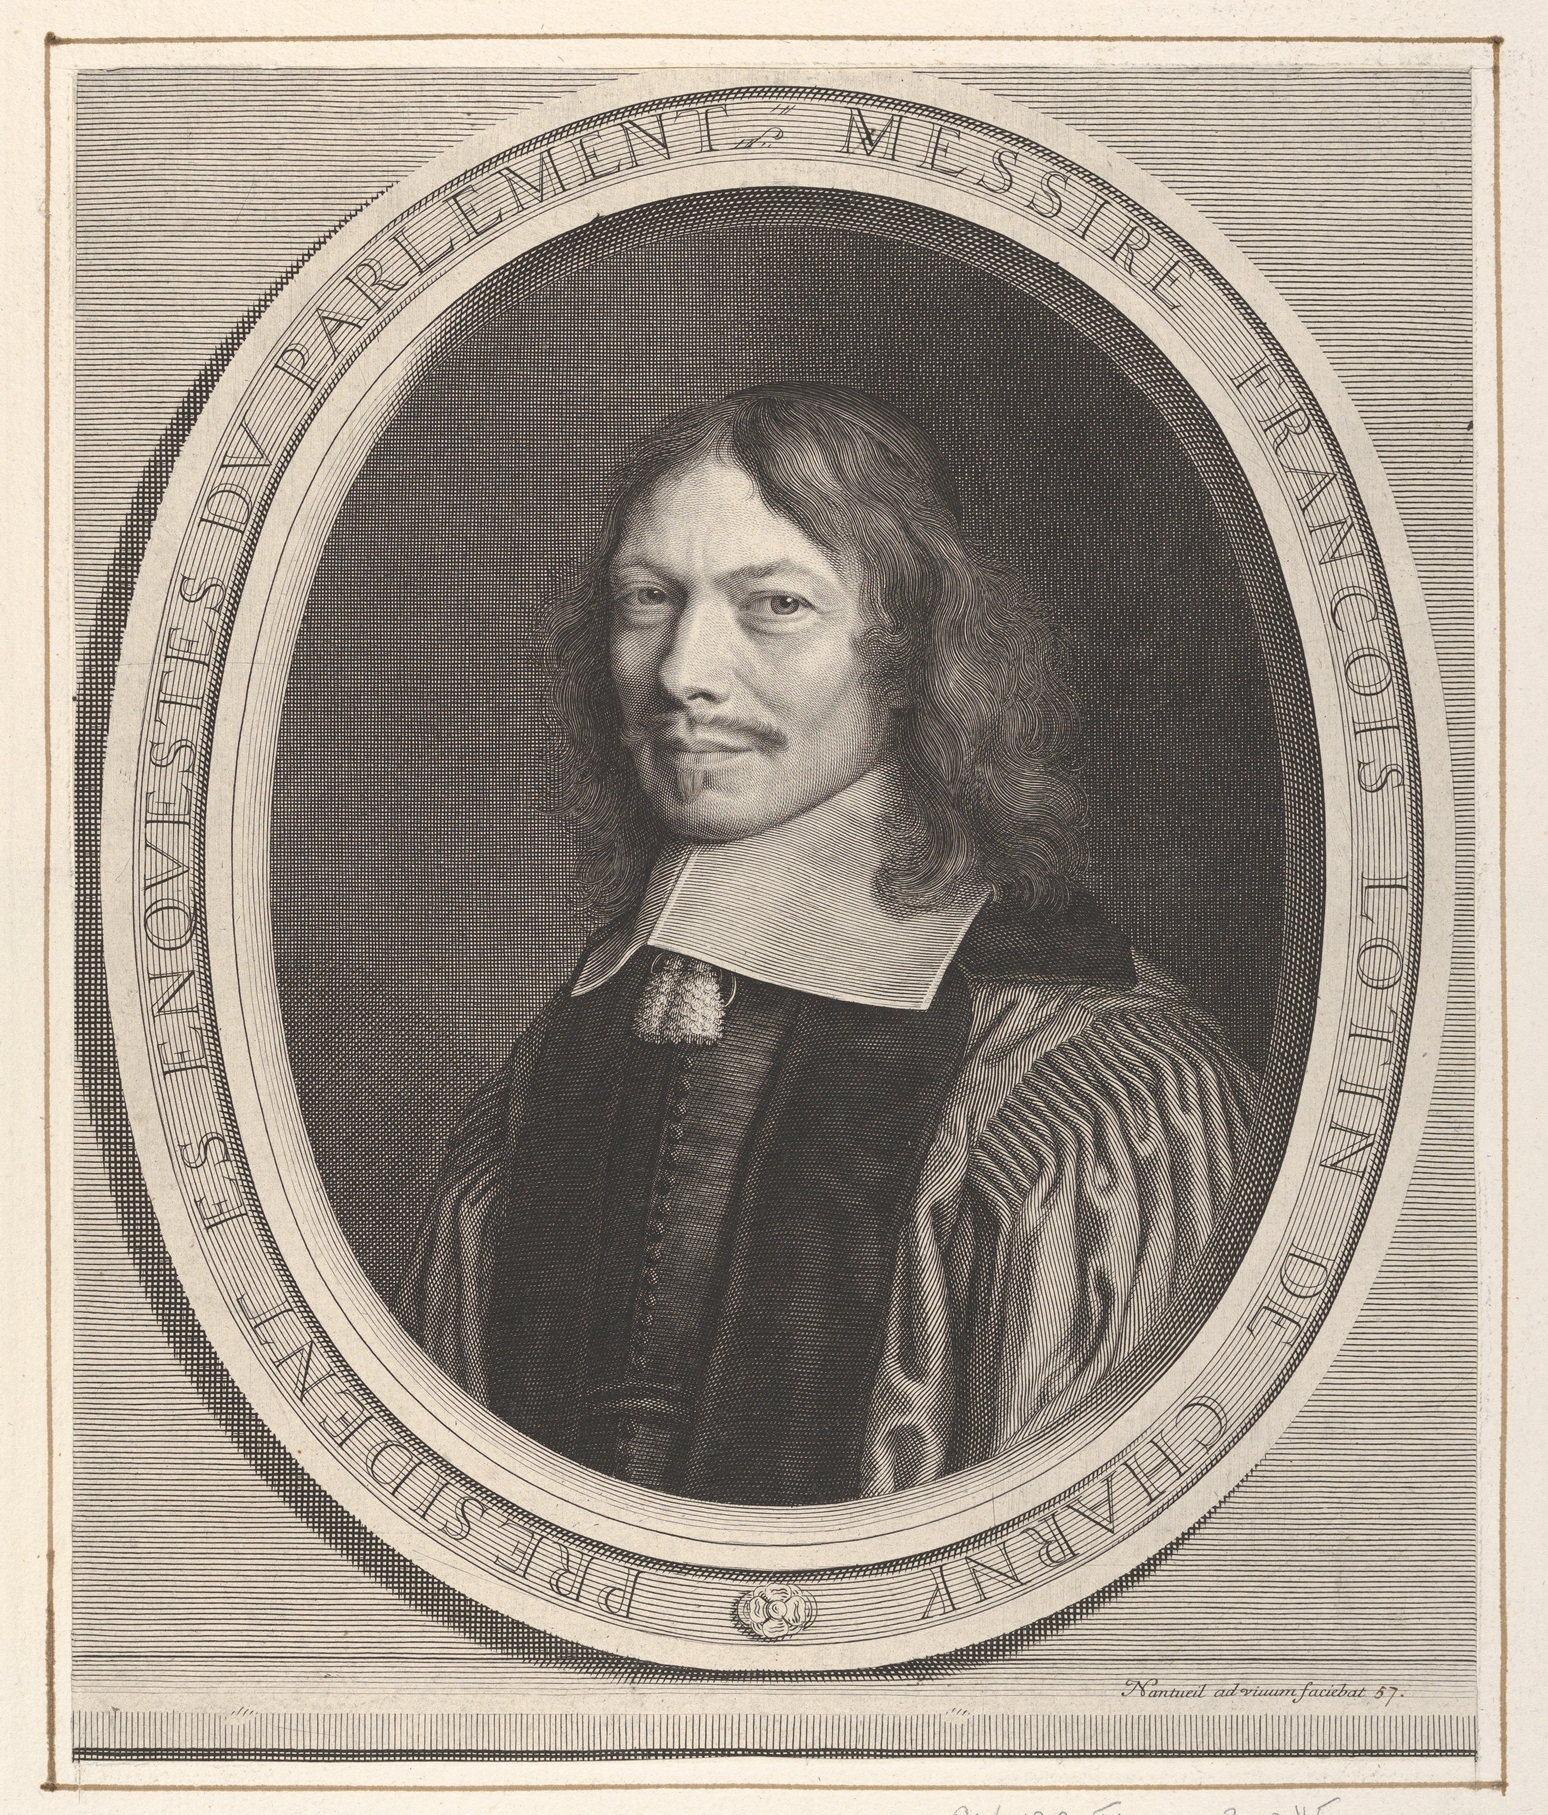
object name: print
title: François Lotin de Charny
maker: robert nanteuil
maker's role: artist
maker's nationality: french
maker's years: 1623-1678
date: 1657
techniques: engraving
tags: men,portraits